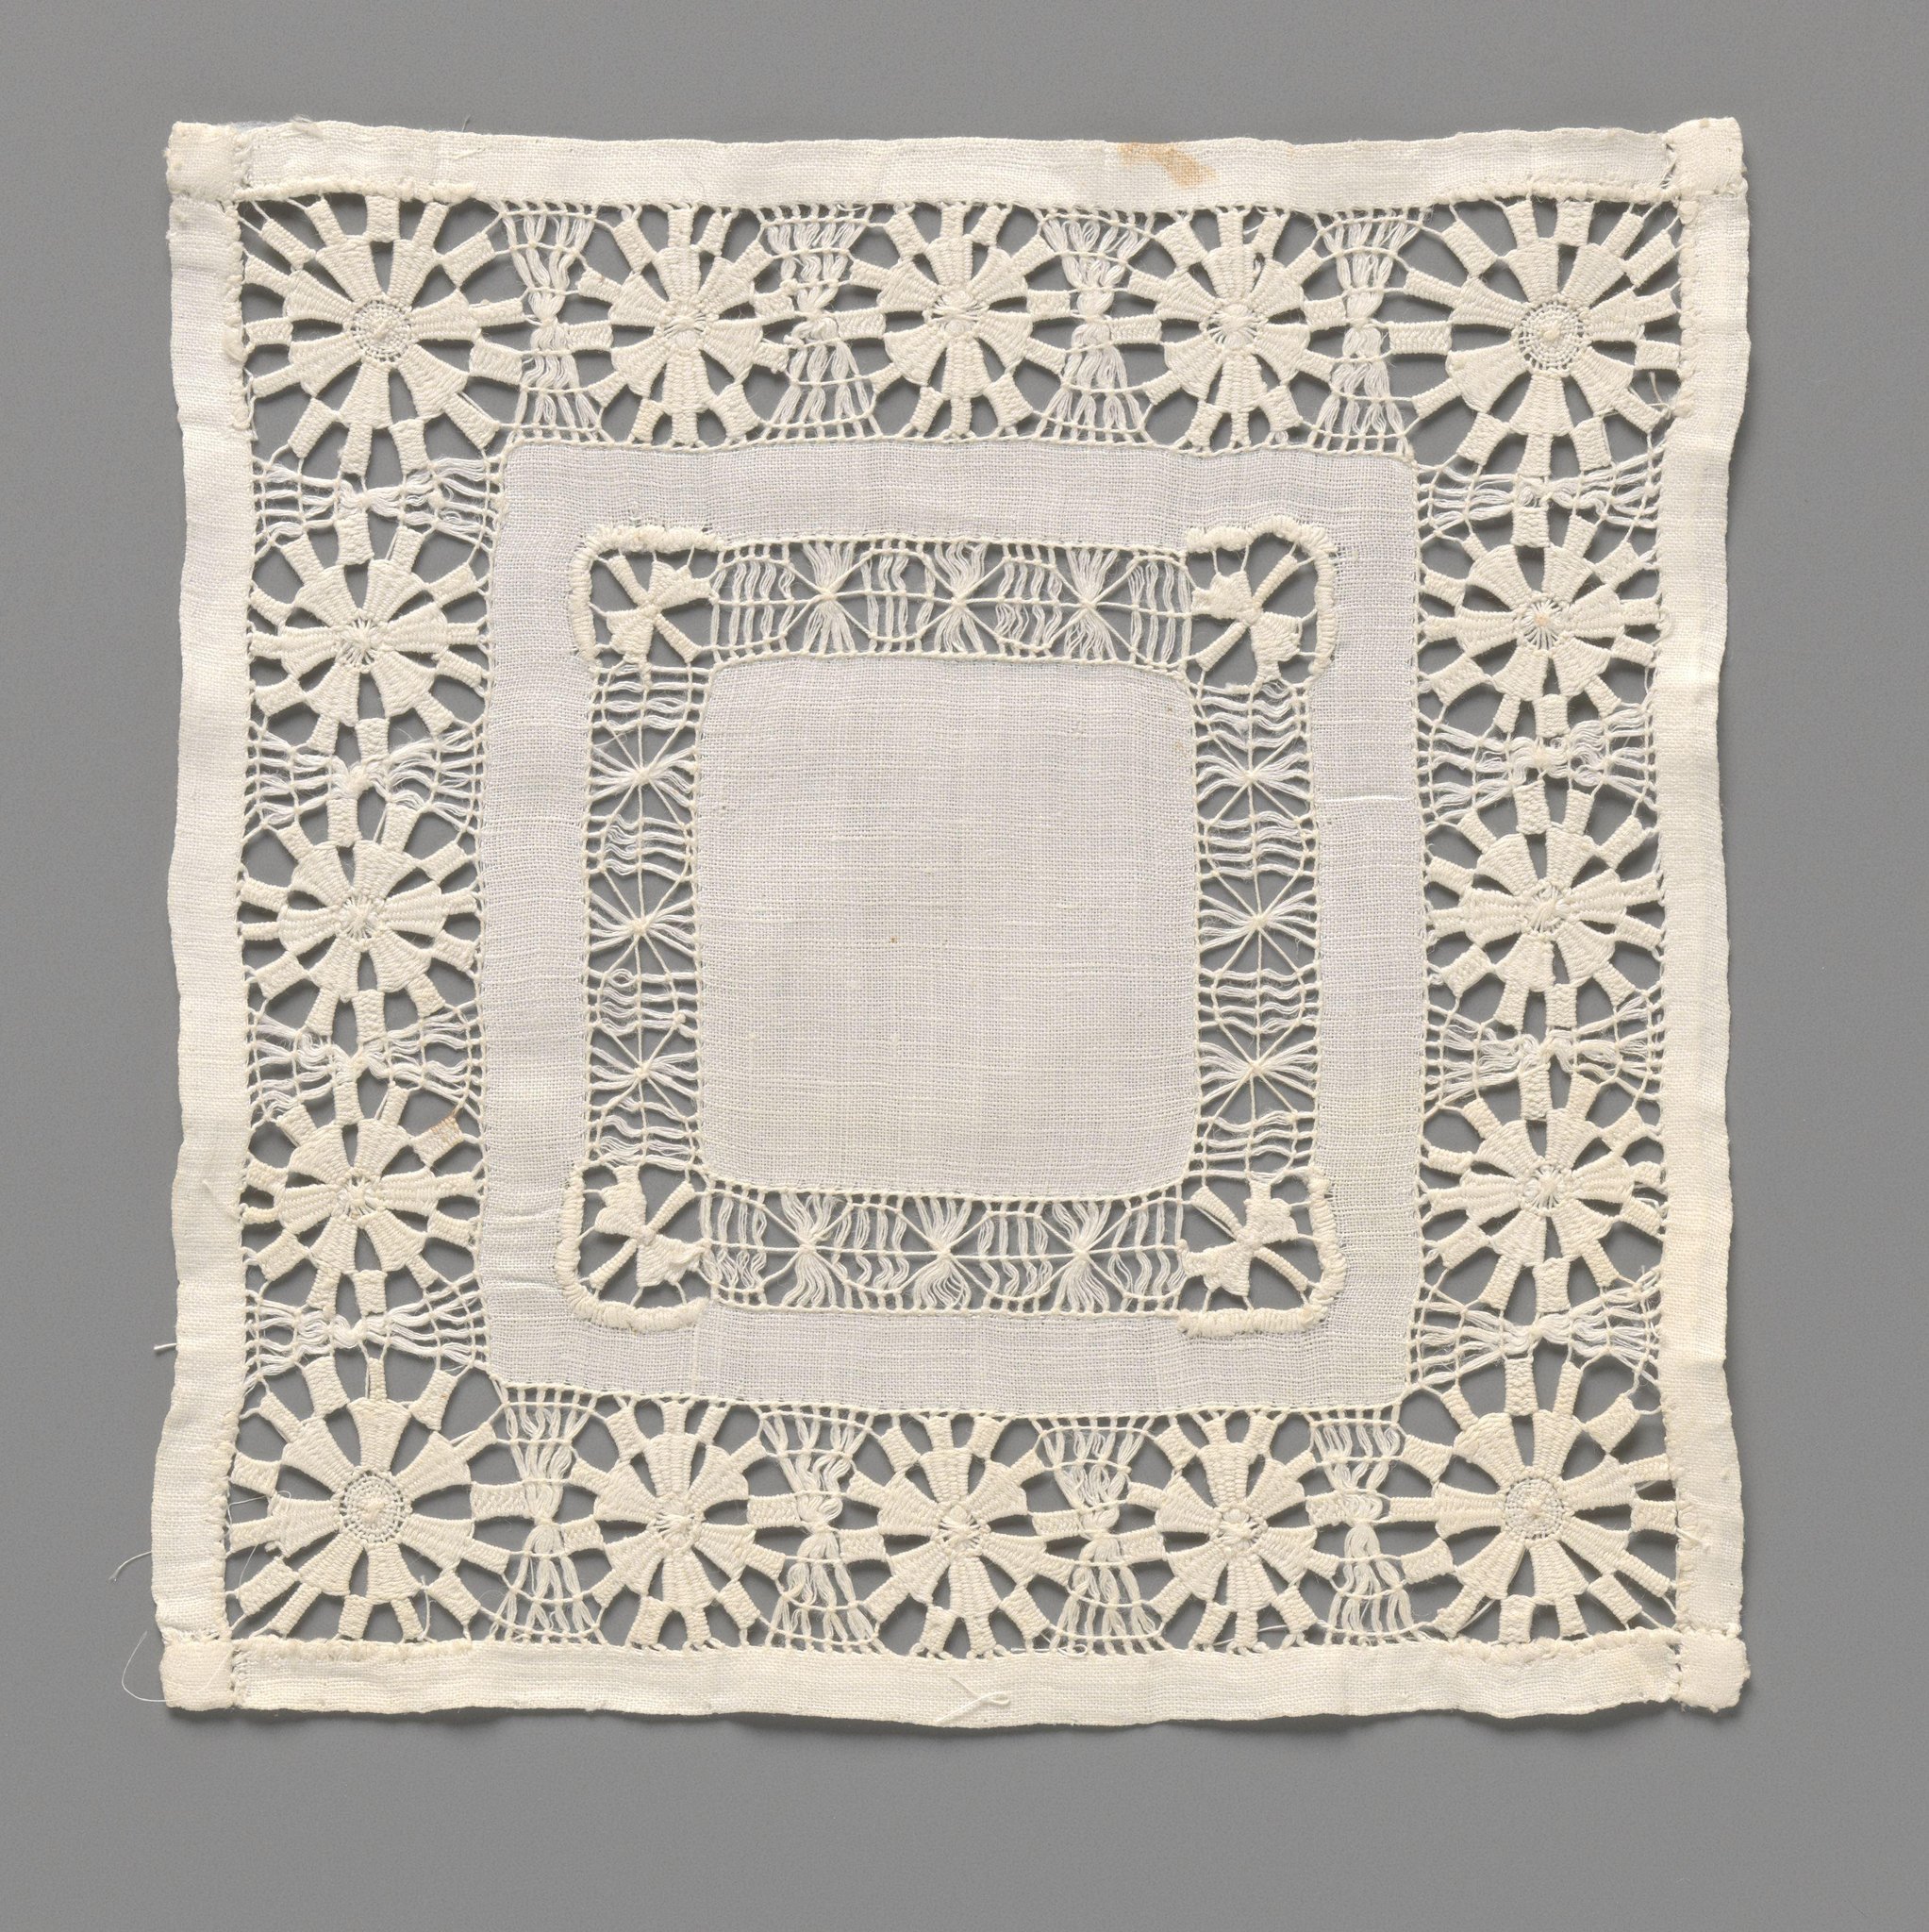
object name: kleed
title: Kleedje van linnen met randen naaldkant met zonnen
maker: Anonymous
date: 1930-1935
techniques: lace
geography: west indies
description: Kleedje van linnen met naturelkleurig naaldkant: Nanduti-werk. Vierkant model met om een vierkant middenstuk van linnen twee randen/lijsten werk met uitgetrokken draden met naaldkantmotieven. In de binnenlijst staan in de hoeken kleine motieven, strikken of vlinders, in naaldkant. In de buitenlijst staan per zijde drie zonnen in naaldkant en in elke hoek een iets grotere zon in naaldkant. Het linnen kleedje is rondom afgewerkt met zoompjes.